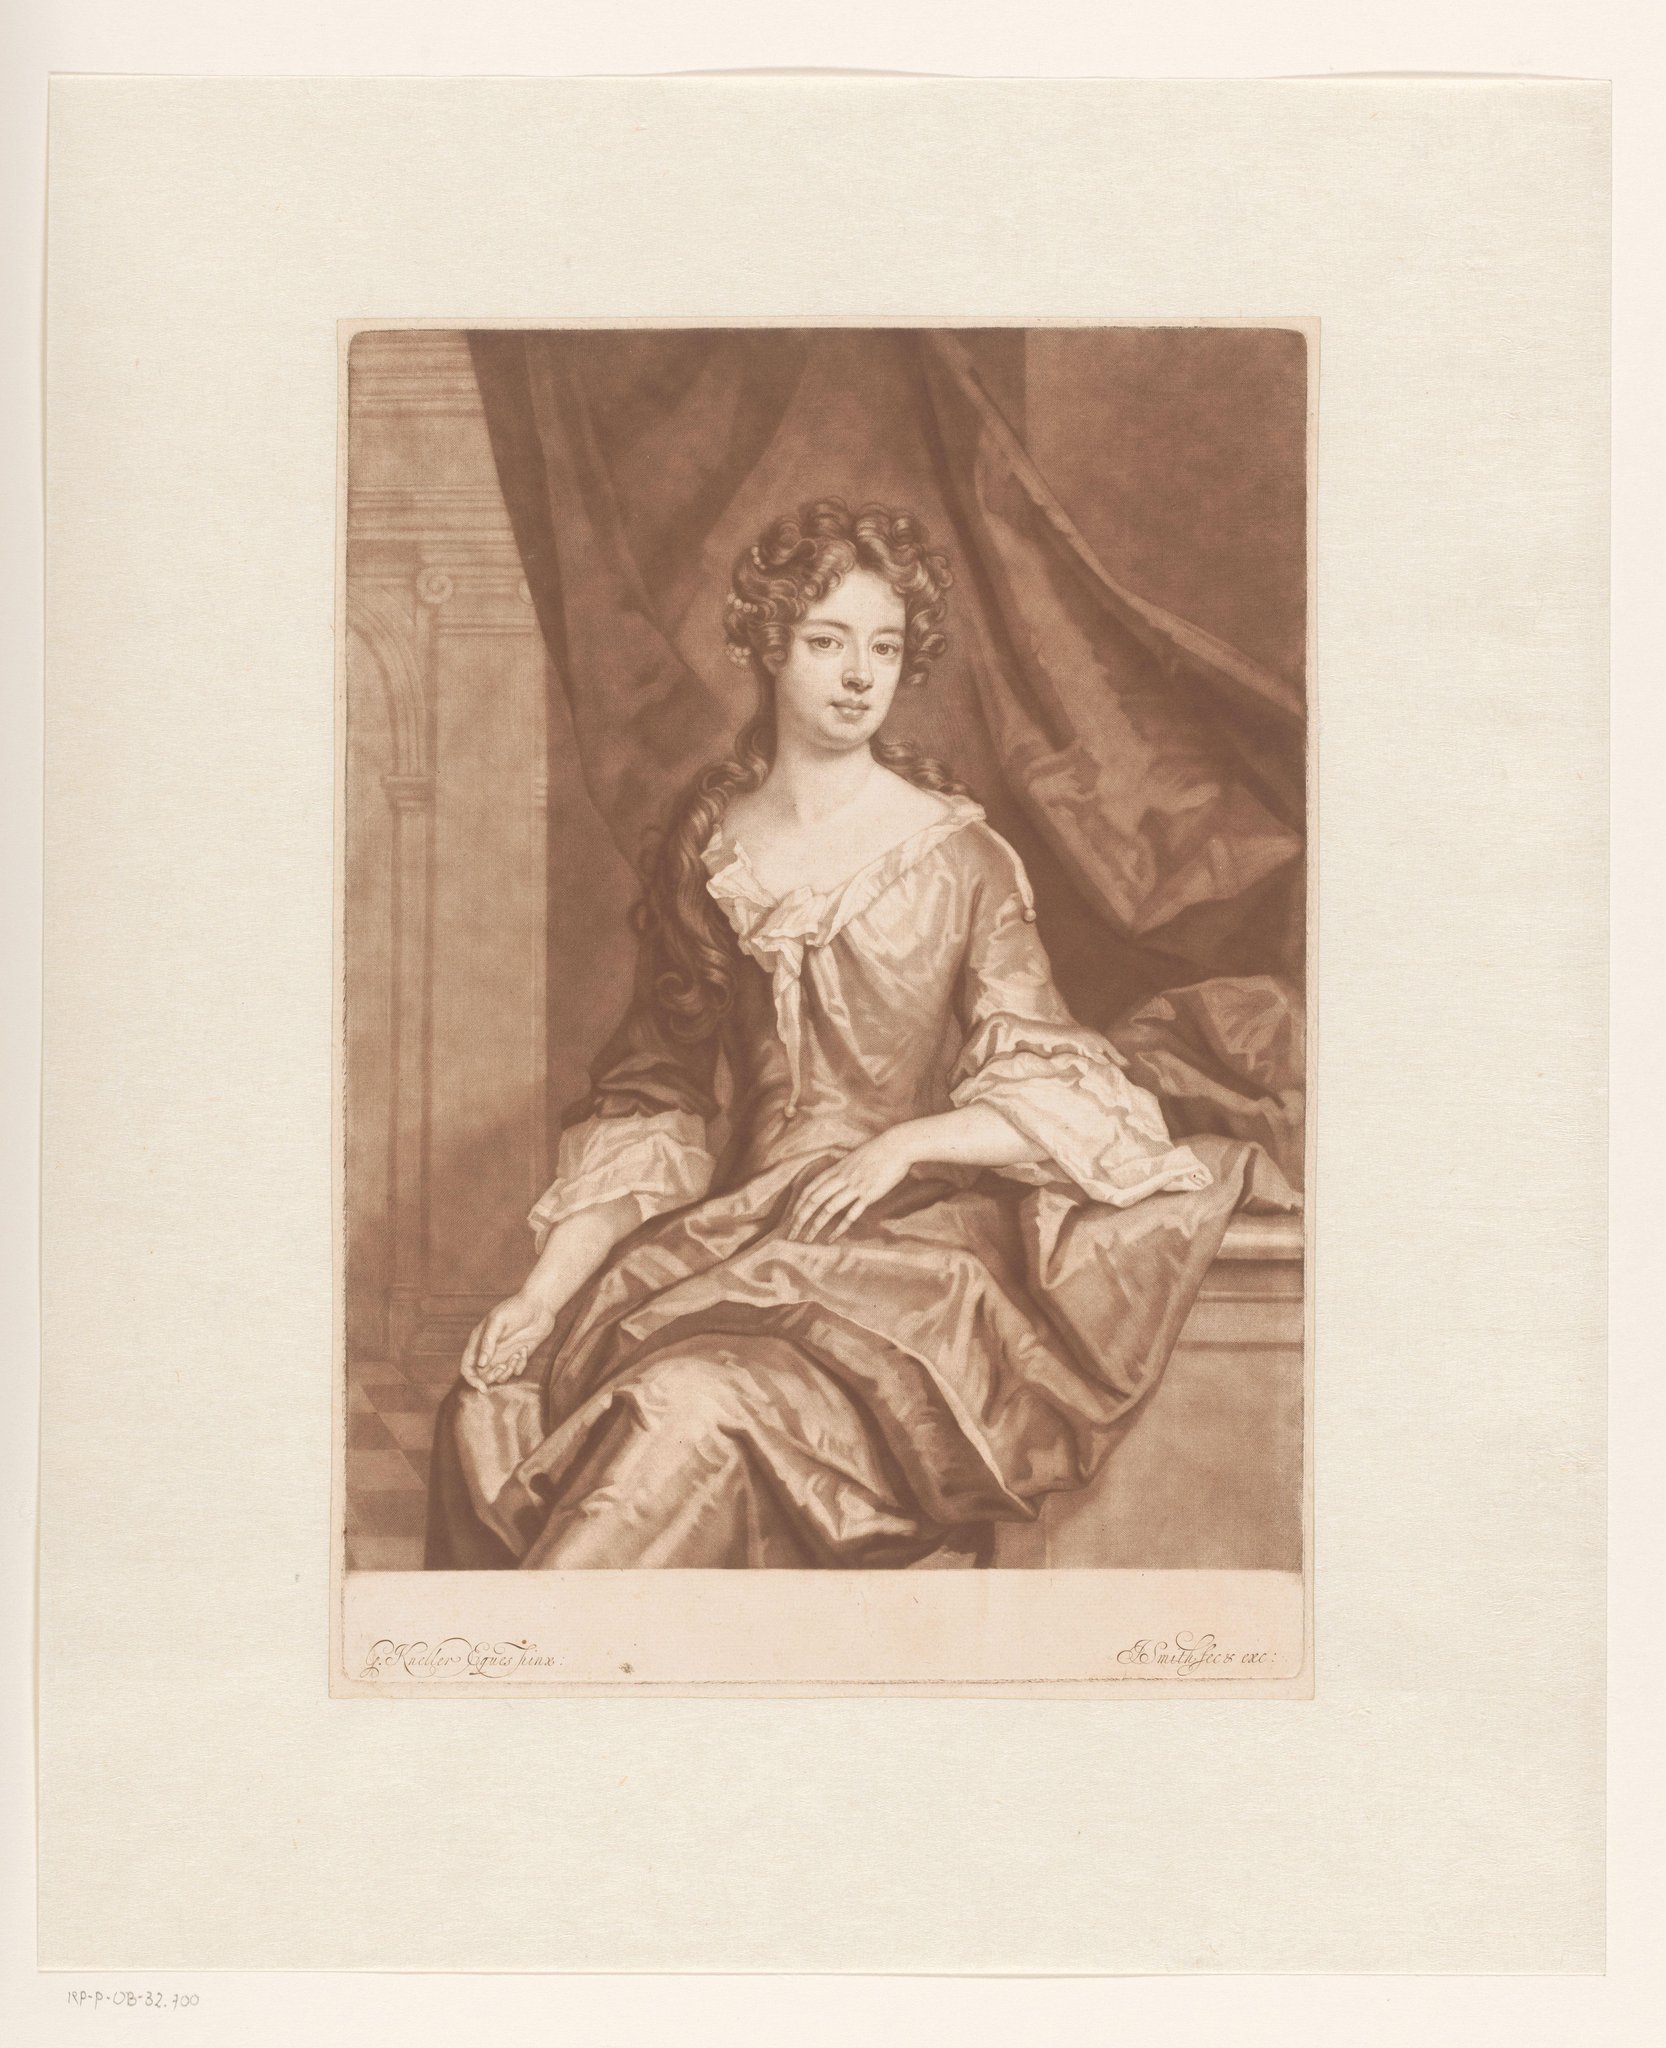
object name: print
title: The Lady Copley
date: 1662-1742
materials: paper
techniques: mezzotint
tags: historical persons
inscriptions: collector's mark: Lugt 240